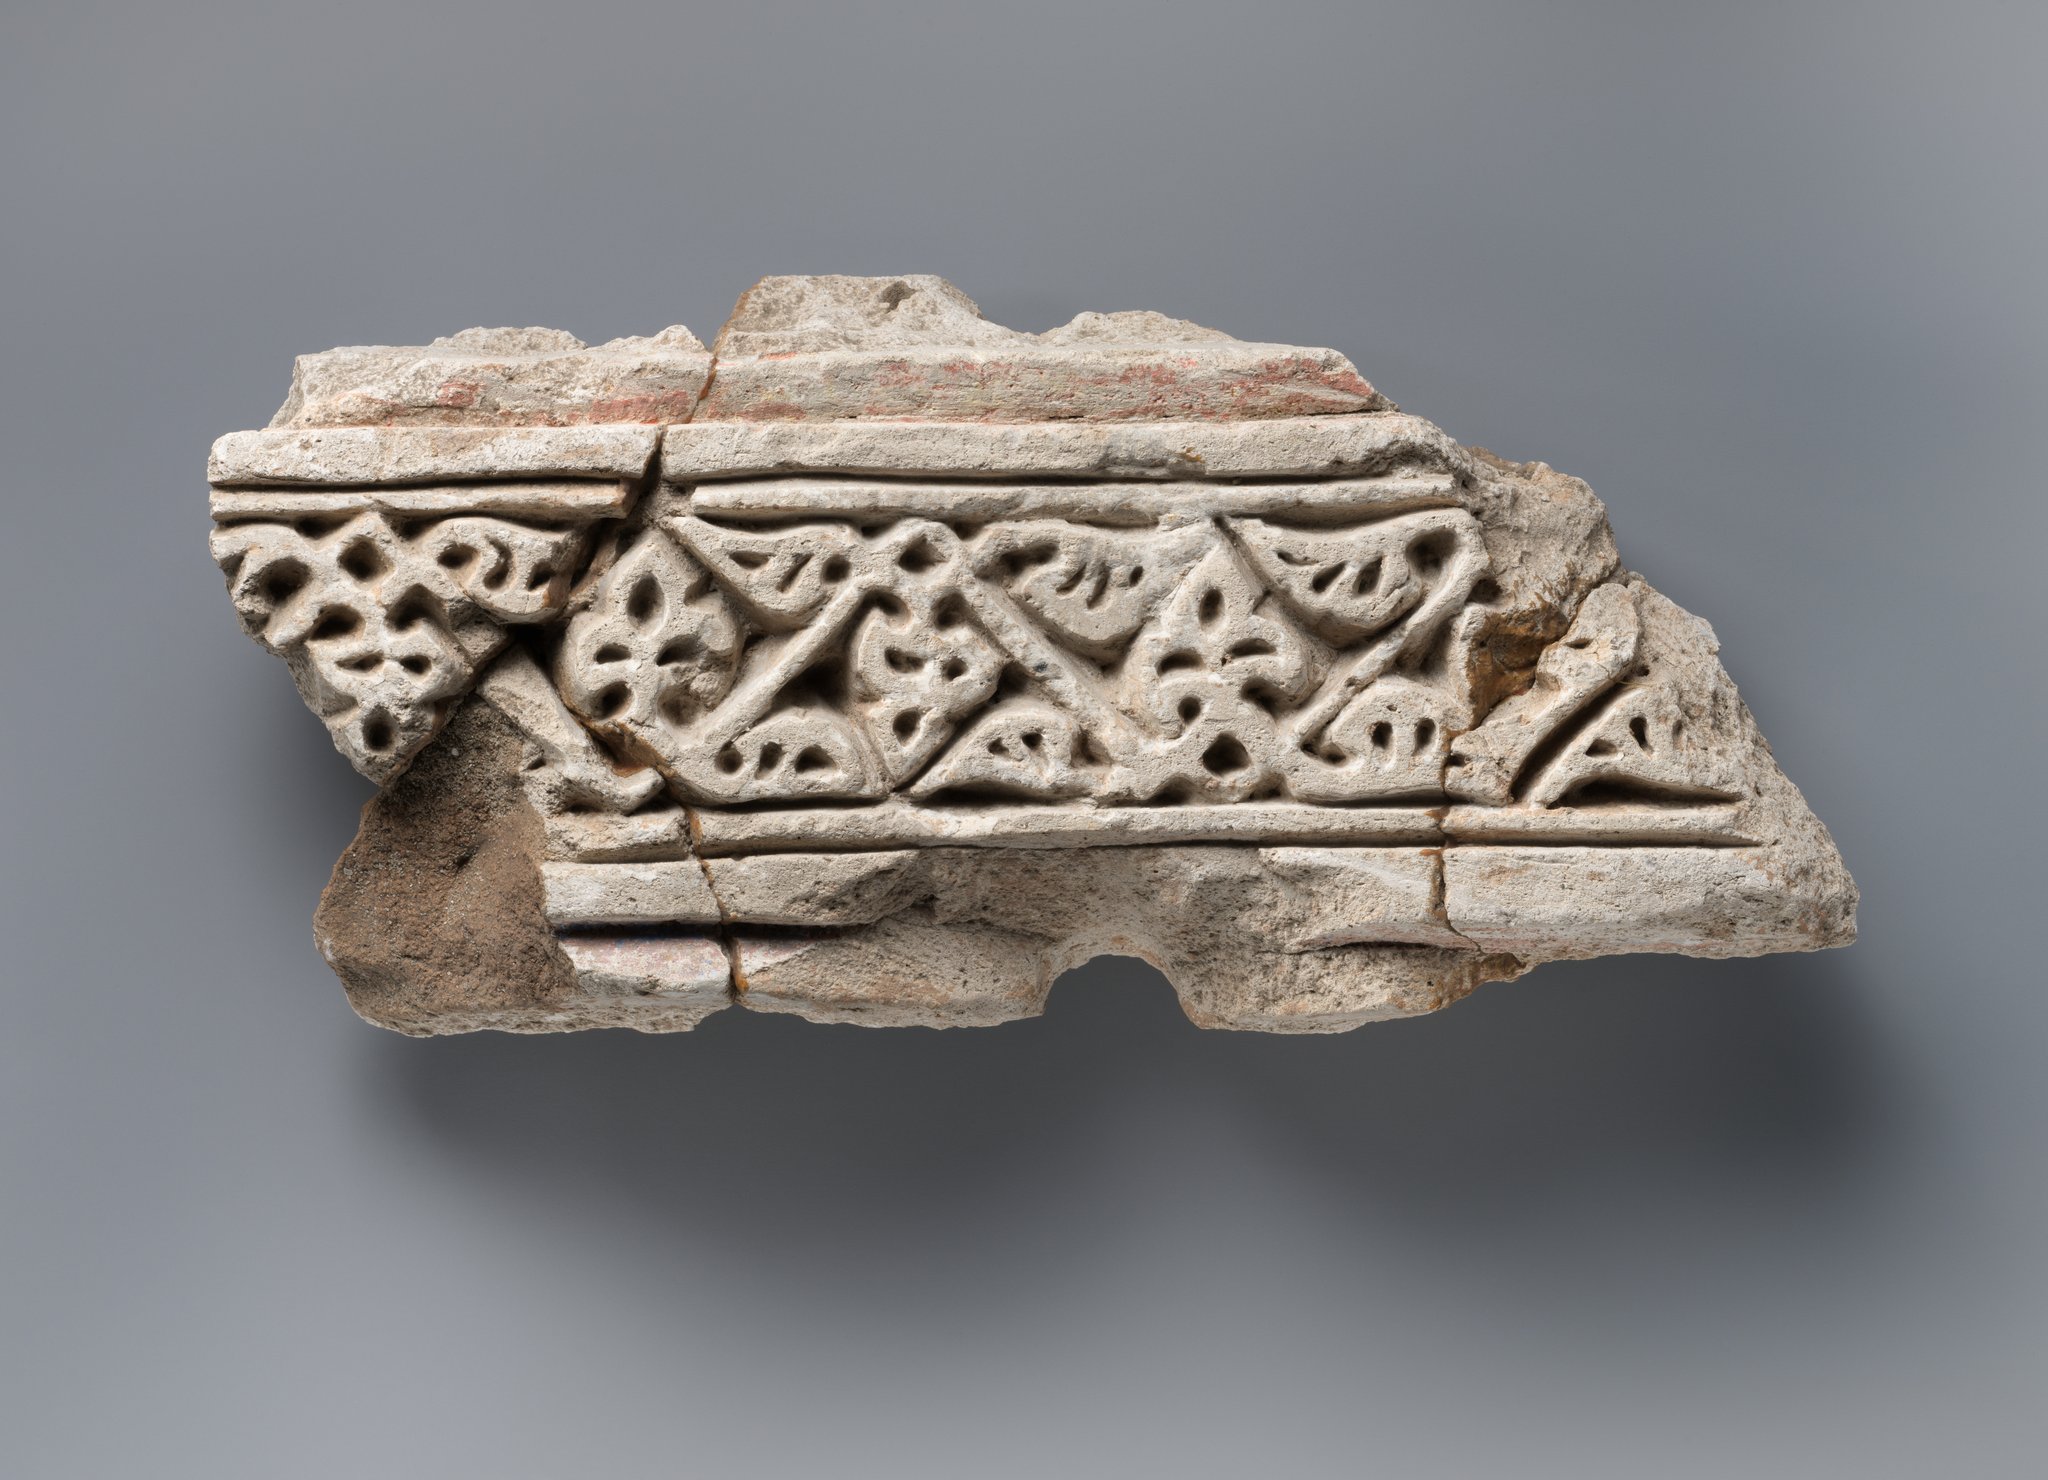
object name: fragment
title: Stucco Fragment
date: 701-1200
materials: plaster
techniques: carving, painting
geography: iran